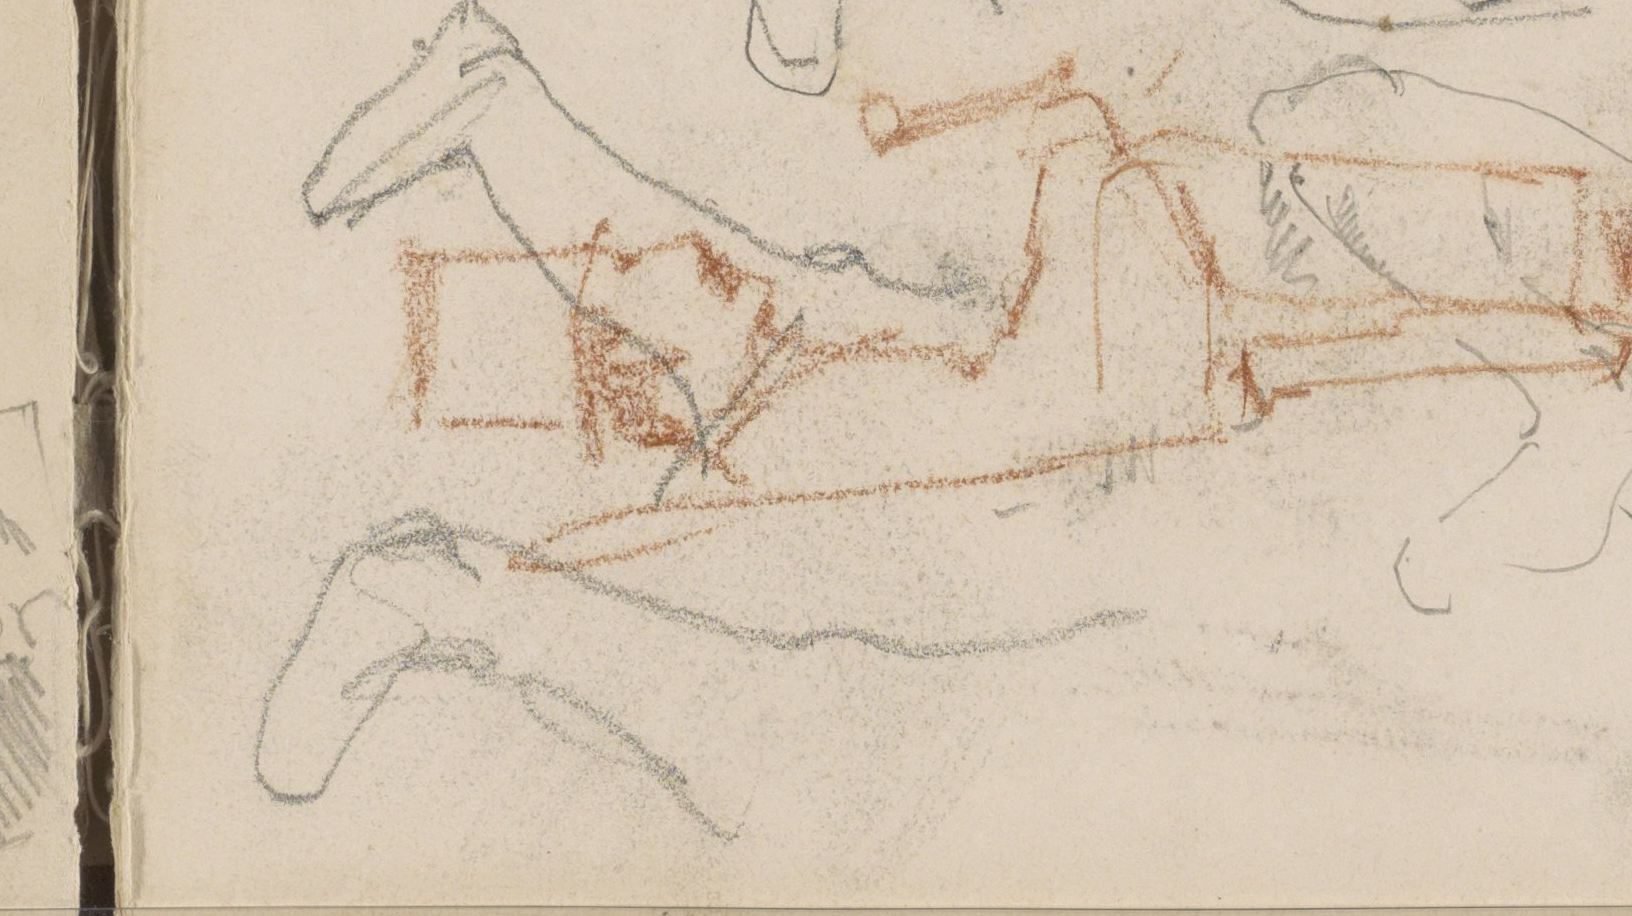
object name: sketchbook leaf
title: Studieblad, onder andere met een zittende man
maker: george hendrik breitner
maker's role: draughtsman, painter, print maker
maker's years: 1857-1923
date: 1880-1882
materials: chalk, paper, pencil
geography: the hague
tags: sheep, horse, sitting on an elevation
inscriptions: workshop stamp: Lugt 291d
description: Verder mogelijk paarden en een schapenkop. Blad 6 recto uit een schetsboek met 16 bladen.